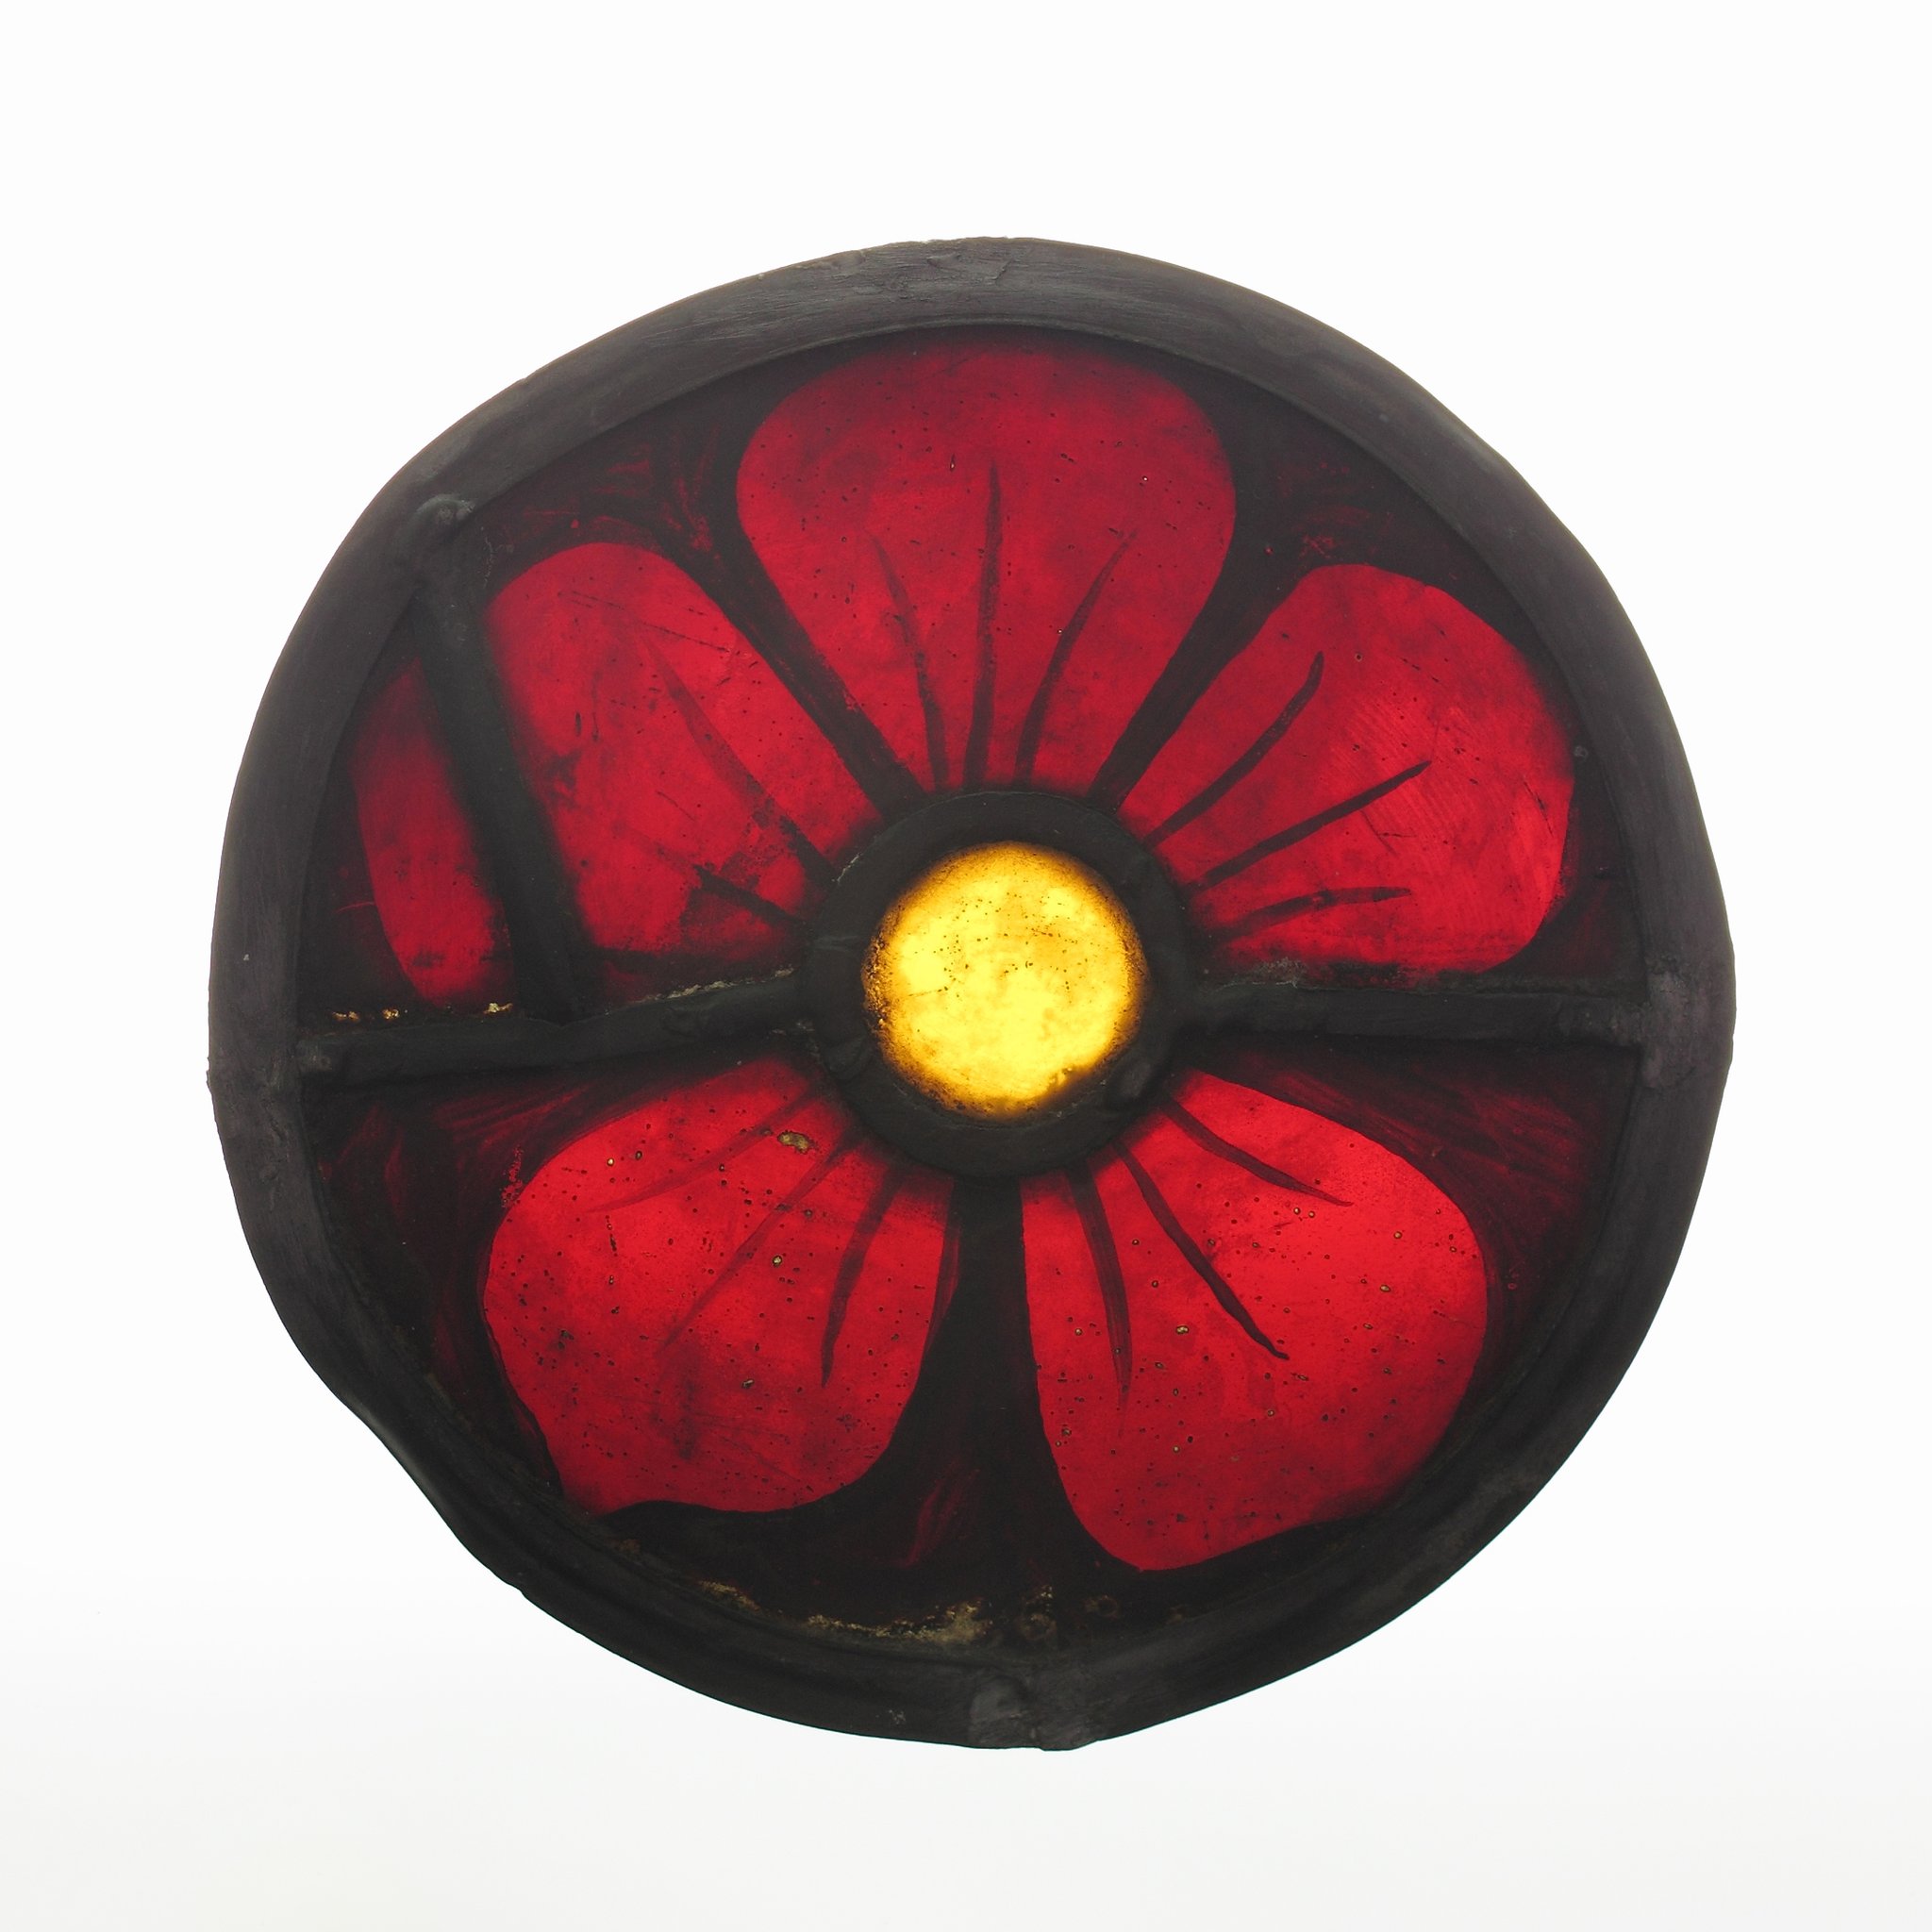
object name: panel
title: Grisaille Panel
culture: french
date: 1325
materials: glass, metal, paint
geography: france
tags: flowers